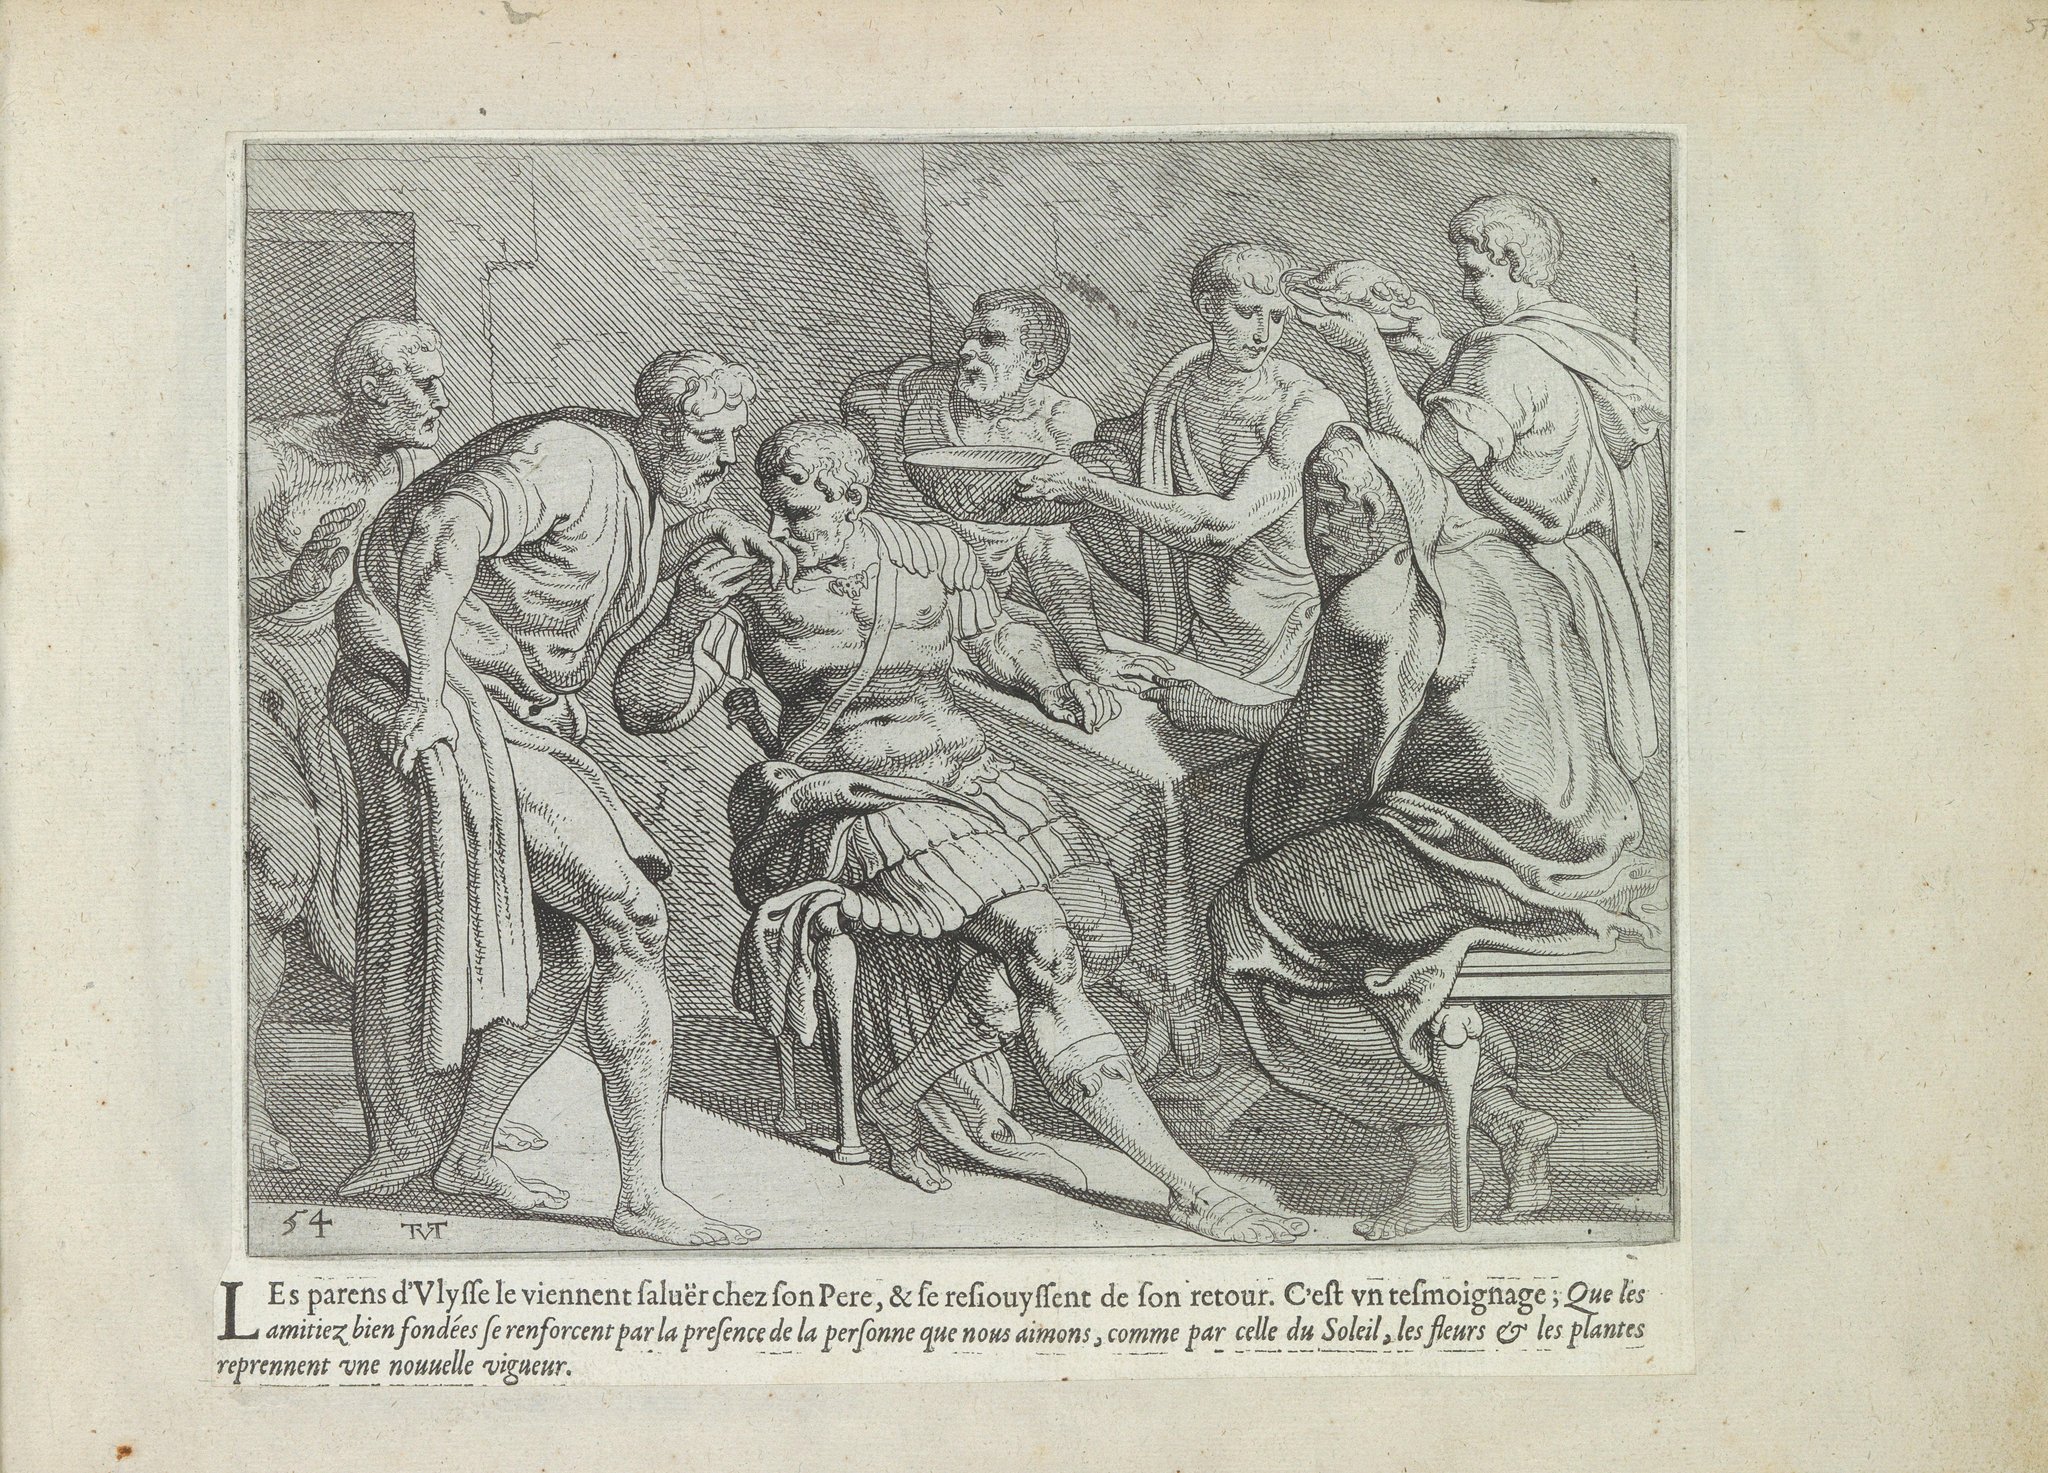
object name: album leaf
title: Les Travaux d'Ulysse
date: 1633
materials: paper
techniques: engraving, etching, letterpress printing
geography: paris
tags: ulysses with his father laertes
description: Dolius laat zijn hand door Odysseus kussen als welkom, voordat ze aan de maaltijd gaan. Naast Odysseus zit zijn vader Laërtes. De prent maakt deel uit van een album.